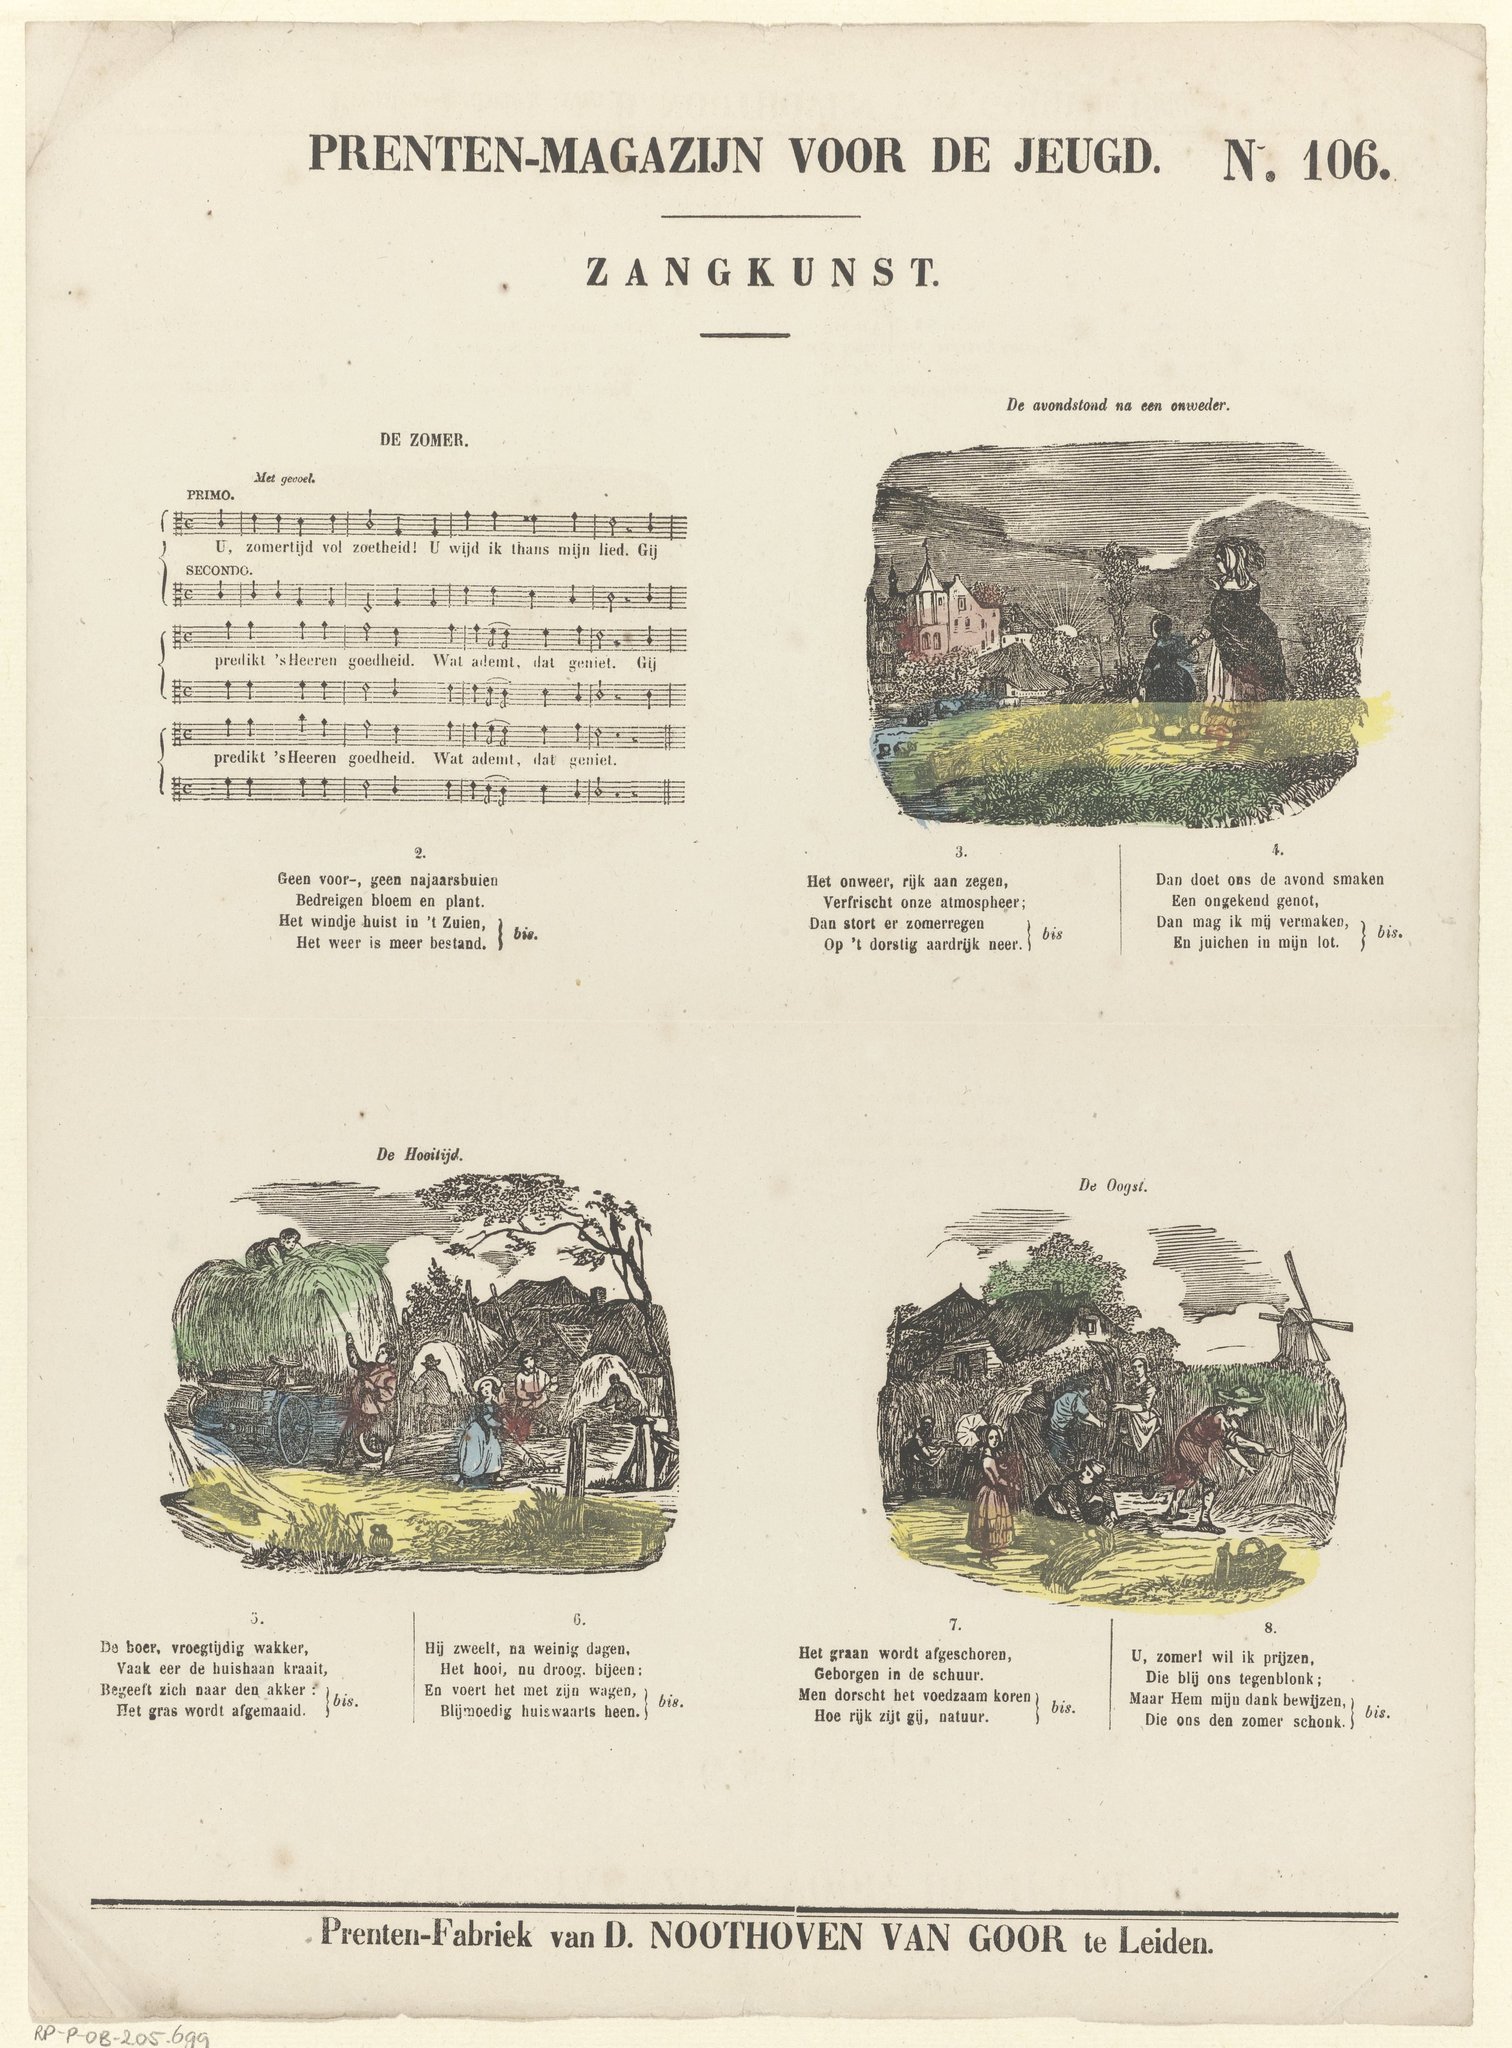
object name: print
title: Prenten-magazijn voor de jeugd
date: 1850-1881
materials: paper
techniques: colour, letterpress printing, engraving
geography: netherlands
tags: seasons of the year represented by scenes showing human activities, usually in a landscape, summer ~ human activities (the four seasons of the year)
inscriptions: collector's mark: Lugt 2760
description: Blad met 3 voorstellingen en een stuk bladmuziek met een lied over de zomer. Boven elke voorstelling een titel en onder elke voorstelling coupletten van het lied. Genummerd rechtsboven: No. 106.